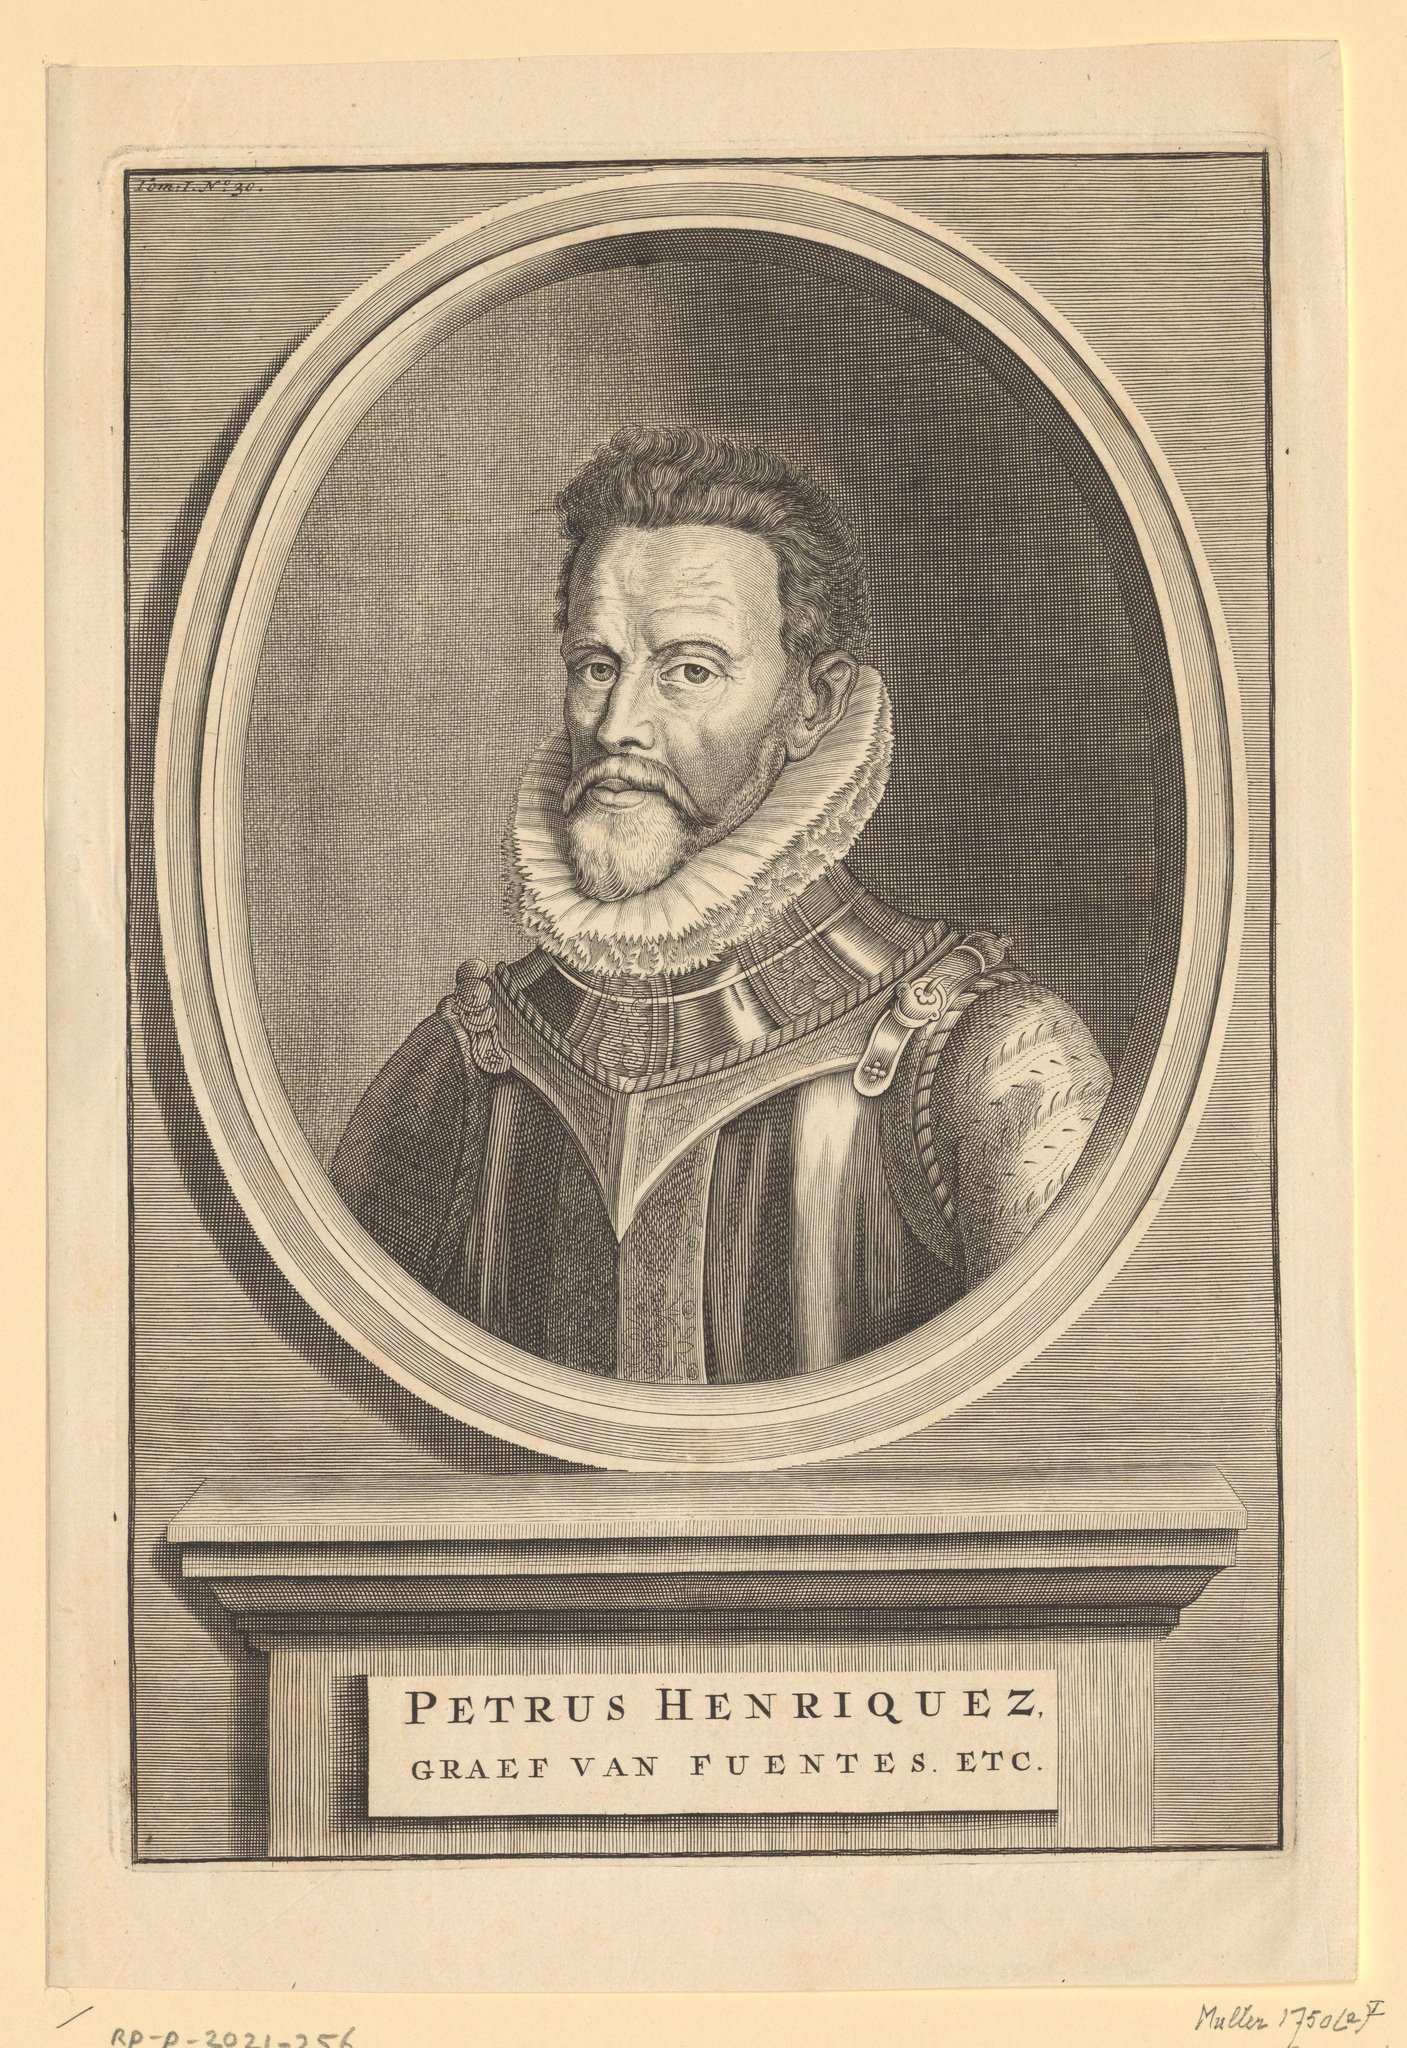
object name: book illustration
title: Portret van Pedro Enríquez de Acevedo, graaf van Fuentes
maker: Anonymous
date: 1730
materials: paper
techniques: engraving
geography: northern netherlands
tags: pedro enríquez de acevedo (count of fuentes), commander-in-chief, general, marshal, armour, historical persons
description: Prent waarschijnlijk uit: Clerc, Jean Le. Geschiedenissen der Vereenigde Nederlanden, sedert den aanvang van die republiek tot op den vrede van Utrecht in 't jaar 1713 en het Tractaat van Barriere in't jaar 1715 gesloten. Amsterdam: Zacharias Chatelain, 1730, dl. 1. Prent eerder gebruikt in publicaties uit 1681.